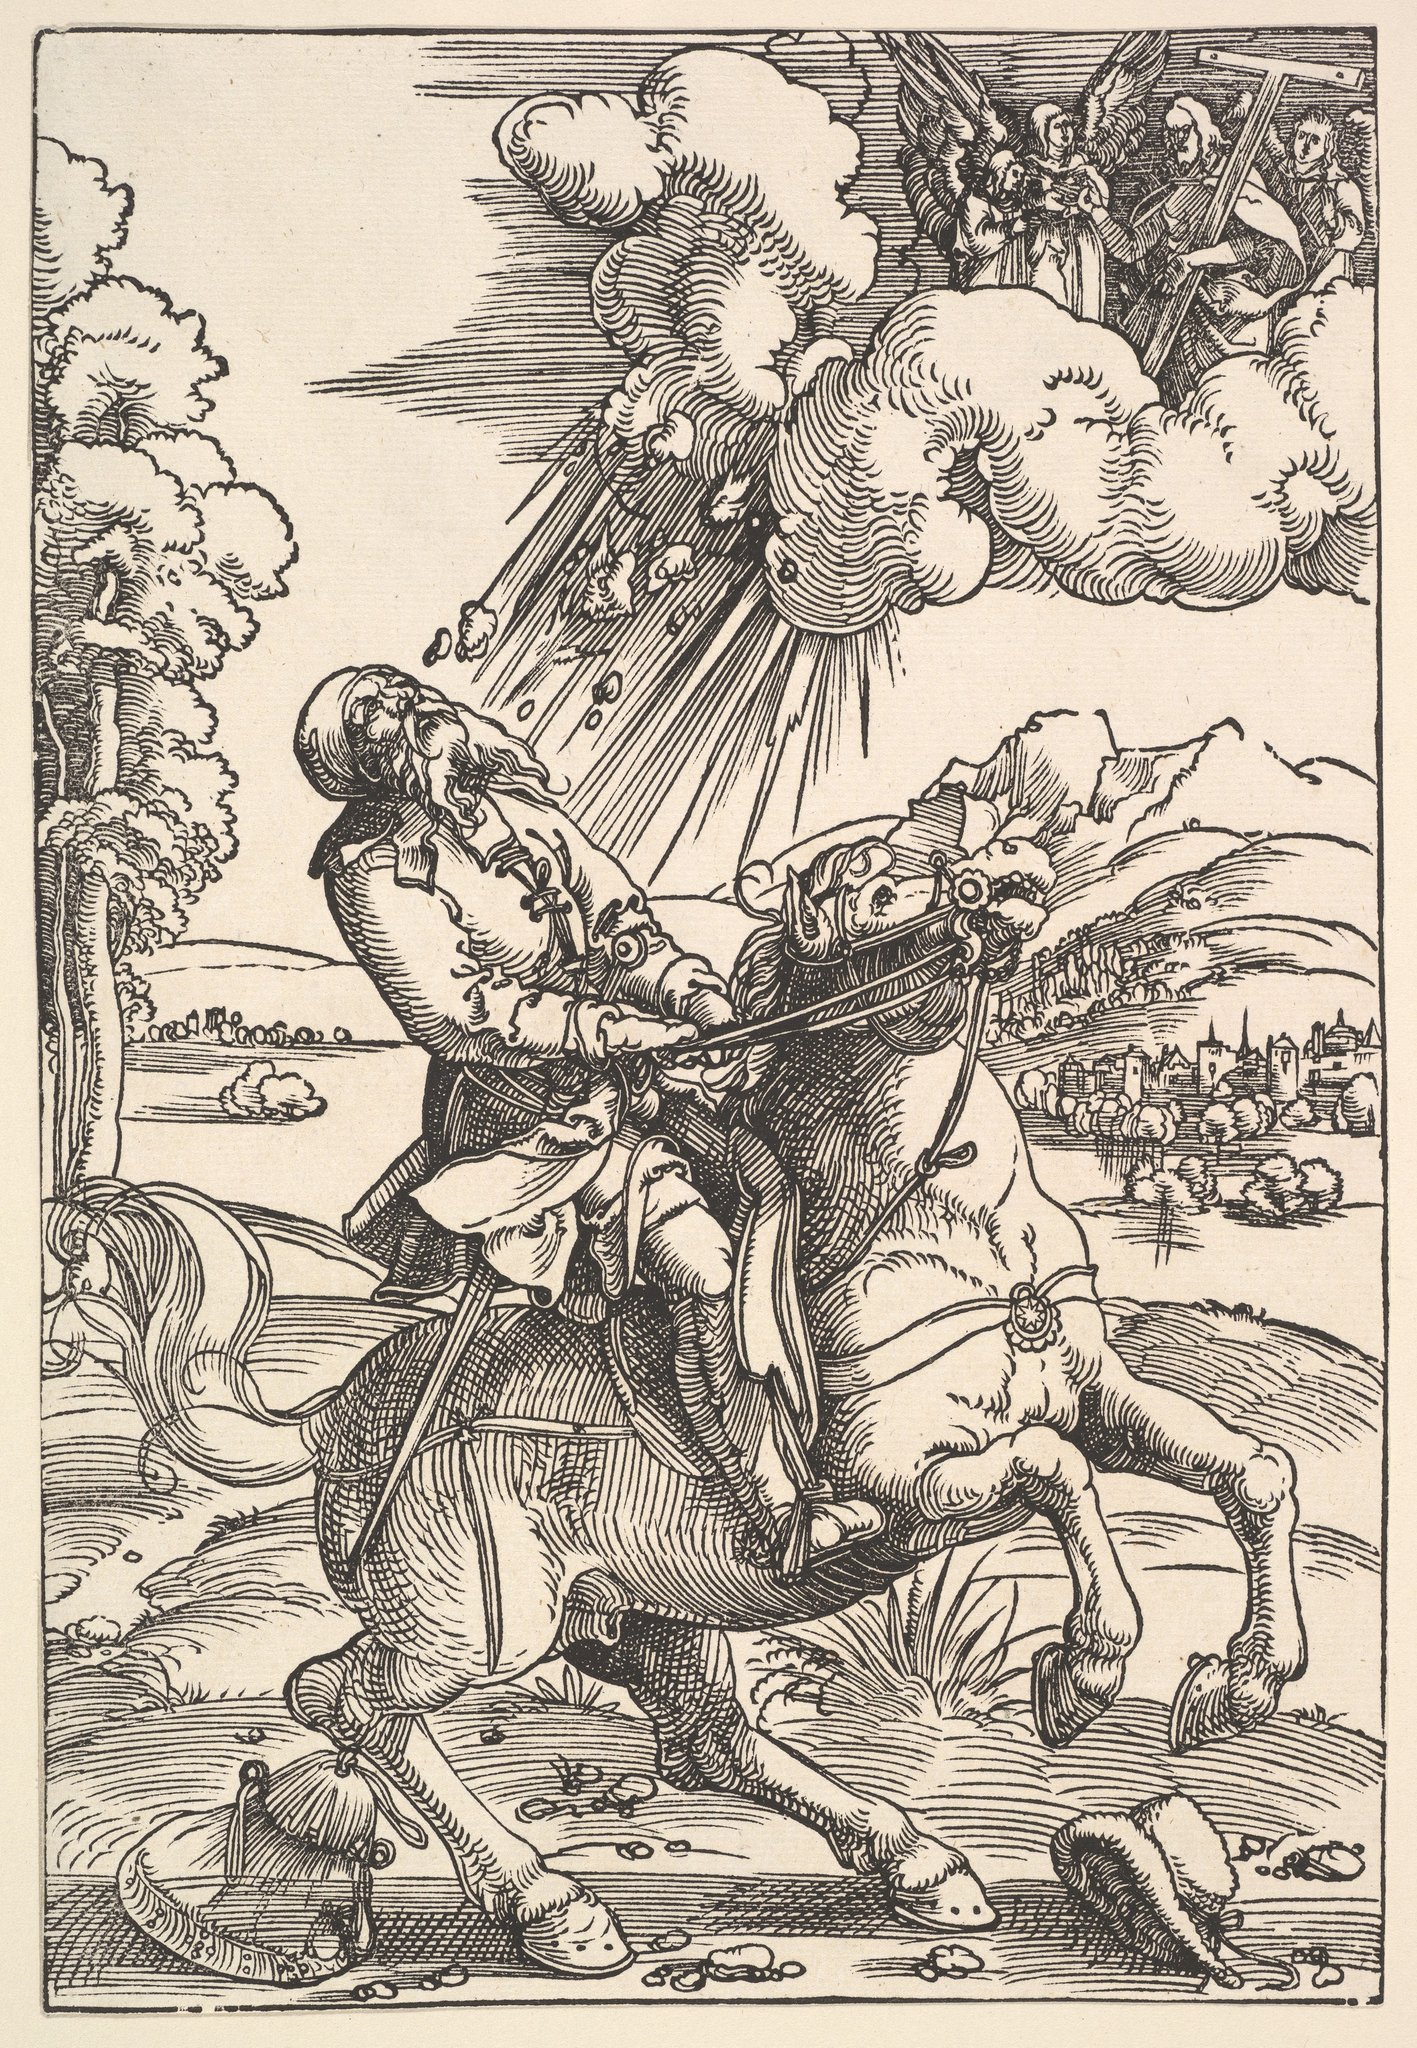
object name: print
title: Conversion of Paul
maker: hans baldung (called hans baldung grien)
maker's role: artist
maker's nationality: german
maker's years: 1484-1545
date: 1508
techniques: woodcut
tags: horses,angels,saint paul,jesus